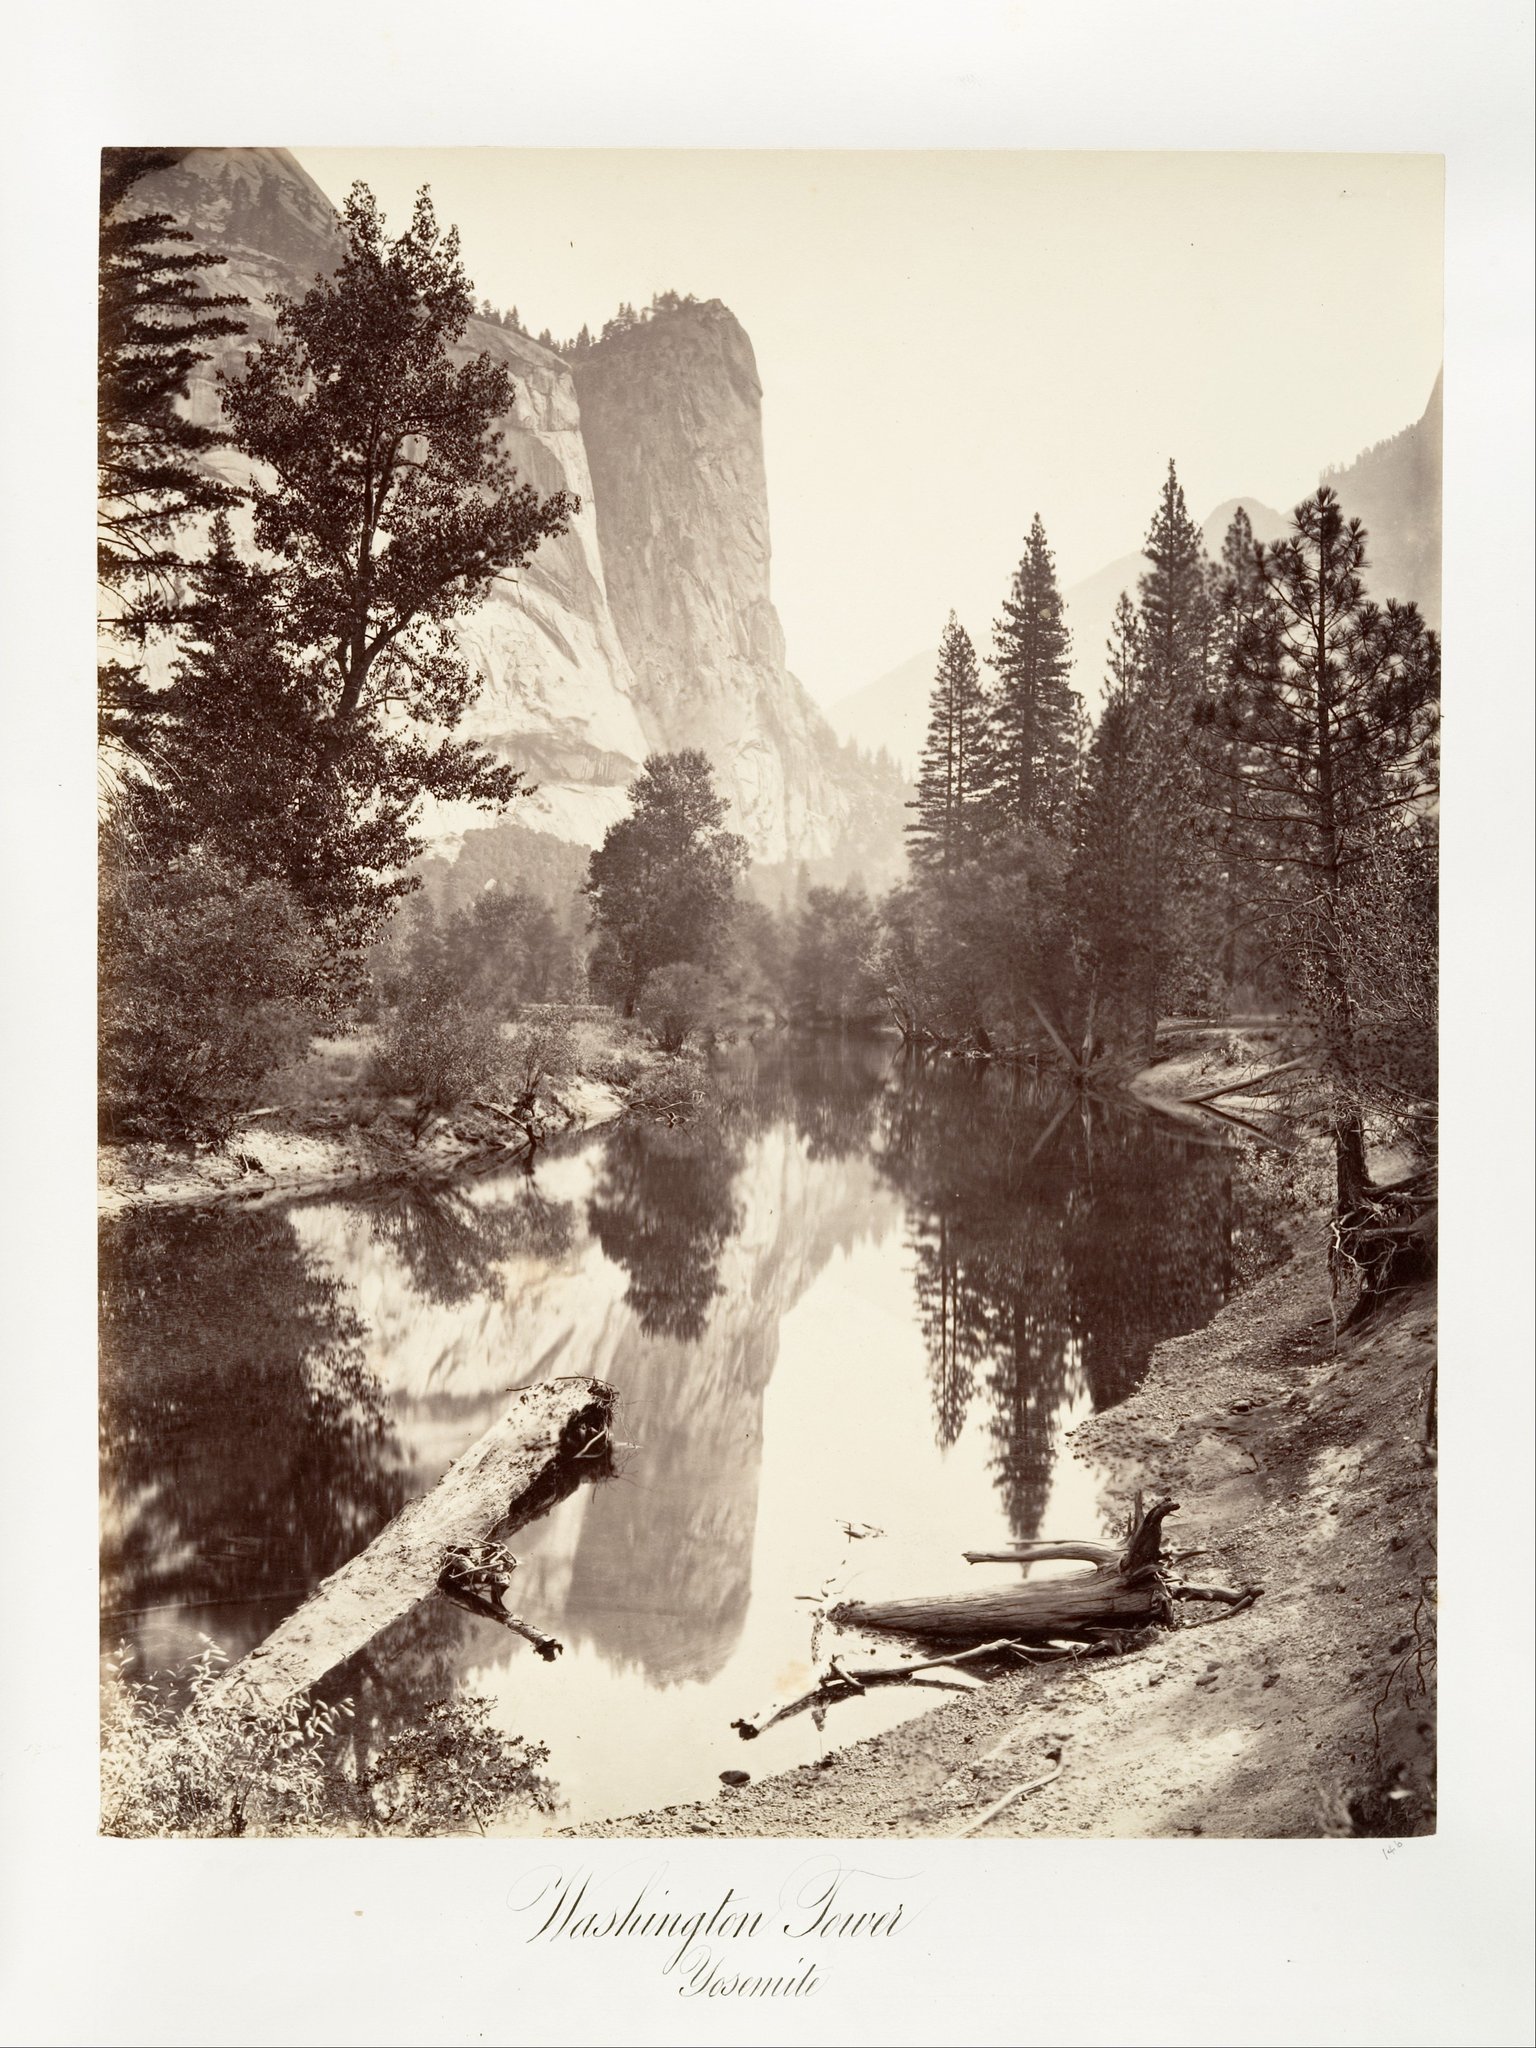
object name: photograph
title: Washington Tower, Yosemite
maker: carleton e. watkins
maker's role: artist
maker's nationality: american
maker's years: 1829-1916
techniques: albumen silver print, glass negative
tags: mountains,landscapes